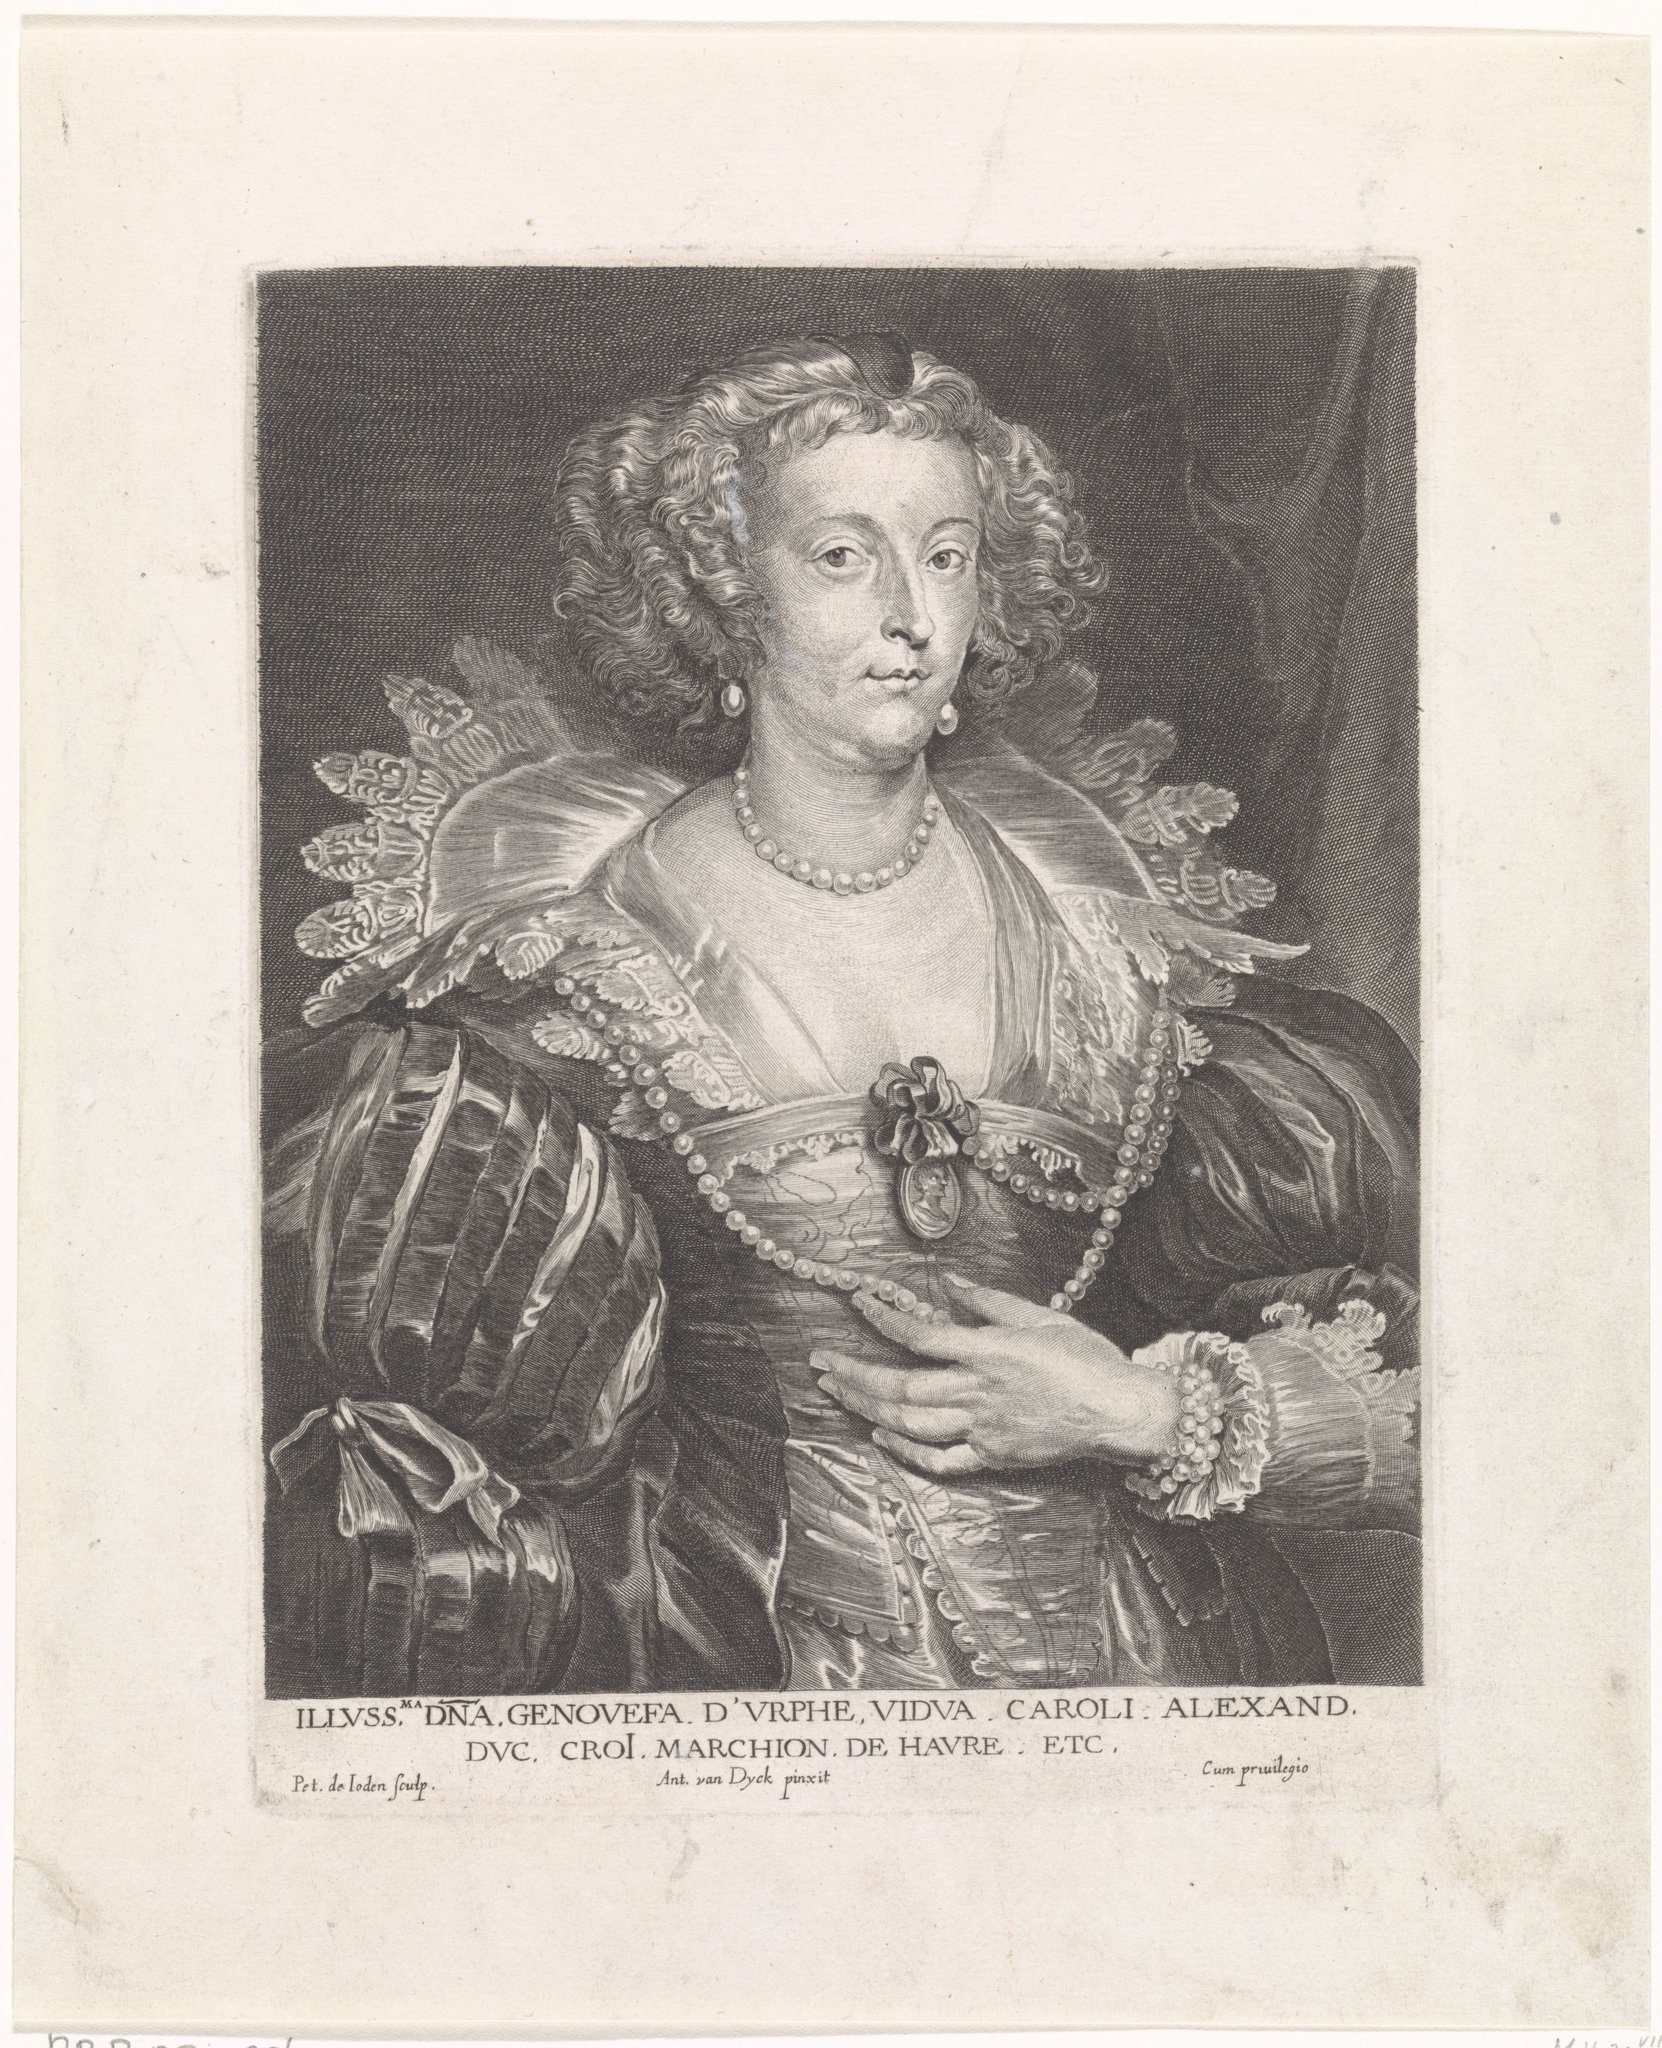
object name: print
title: Portret van Geneviève d'Urfé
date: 1628-1670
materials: paper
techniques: engraving, etching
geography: antwerp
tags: hertogin, geneviève d'urfé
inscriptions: collector's mark: Lugt 2228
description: Portret van Geneviève d'Urfé, ten halven lijve. Ze houdt haar linkerhand tegen haar buik. In de marge de naam van de geportretteerde.